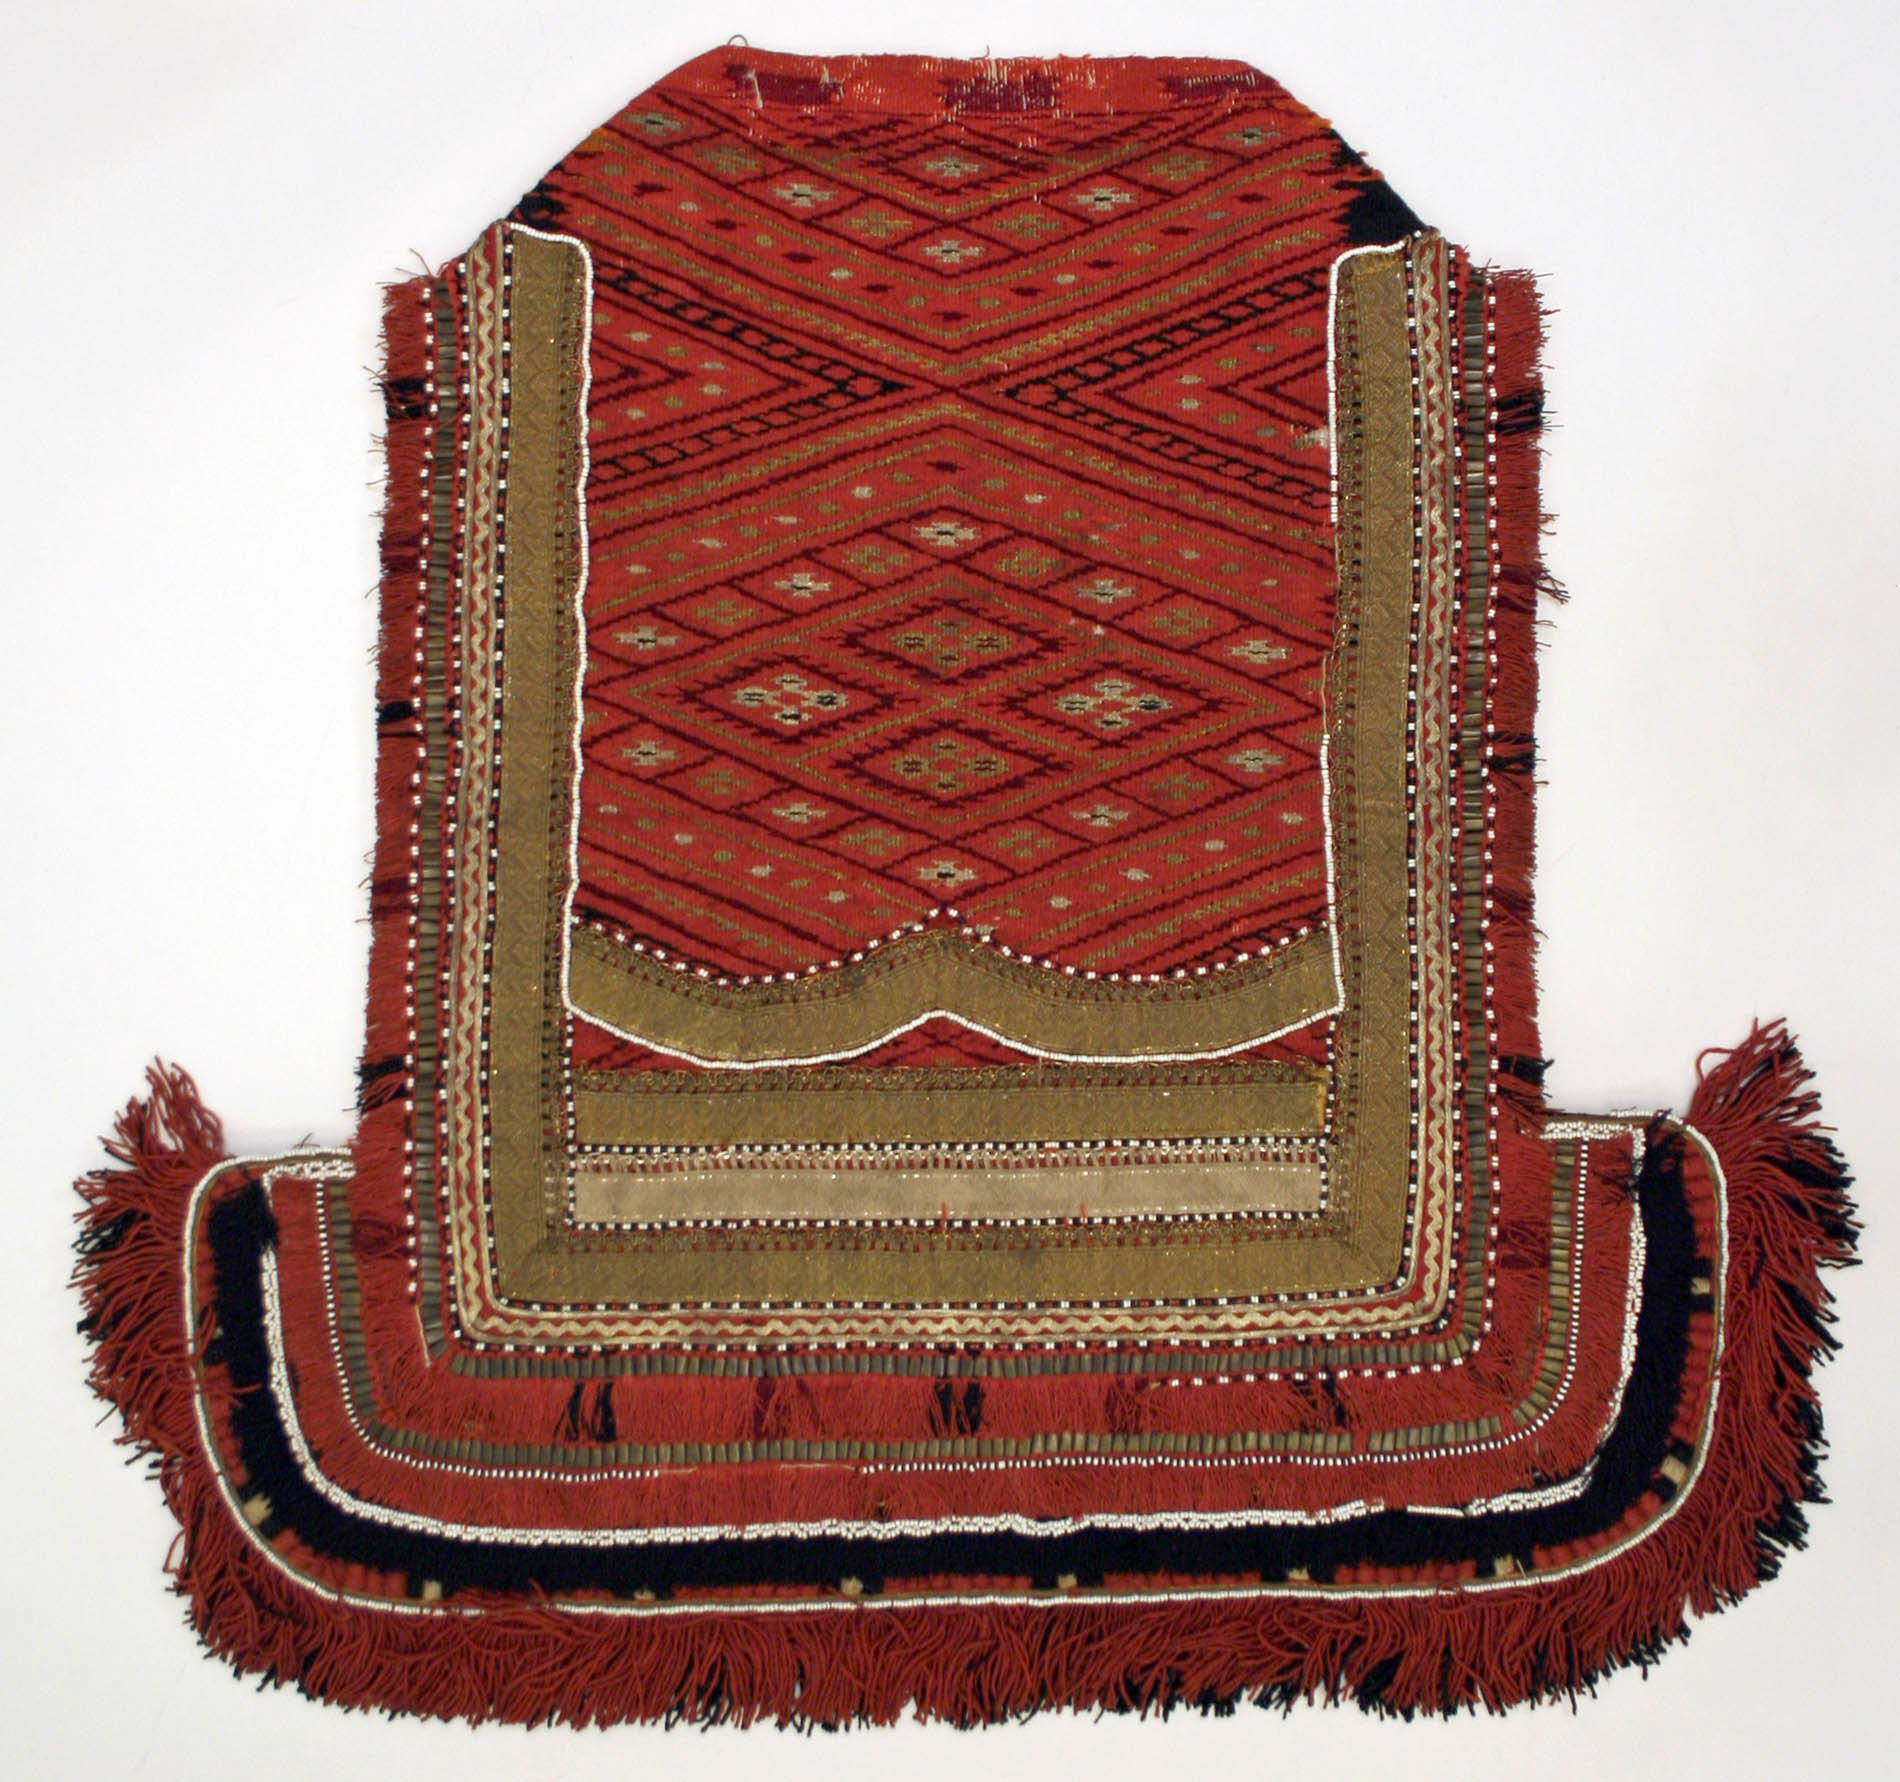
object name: apron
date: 1801-1900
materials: wool